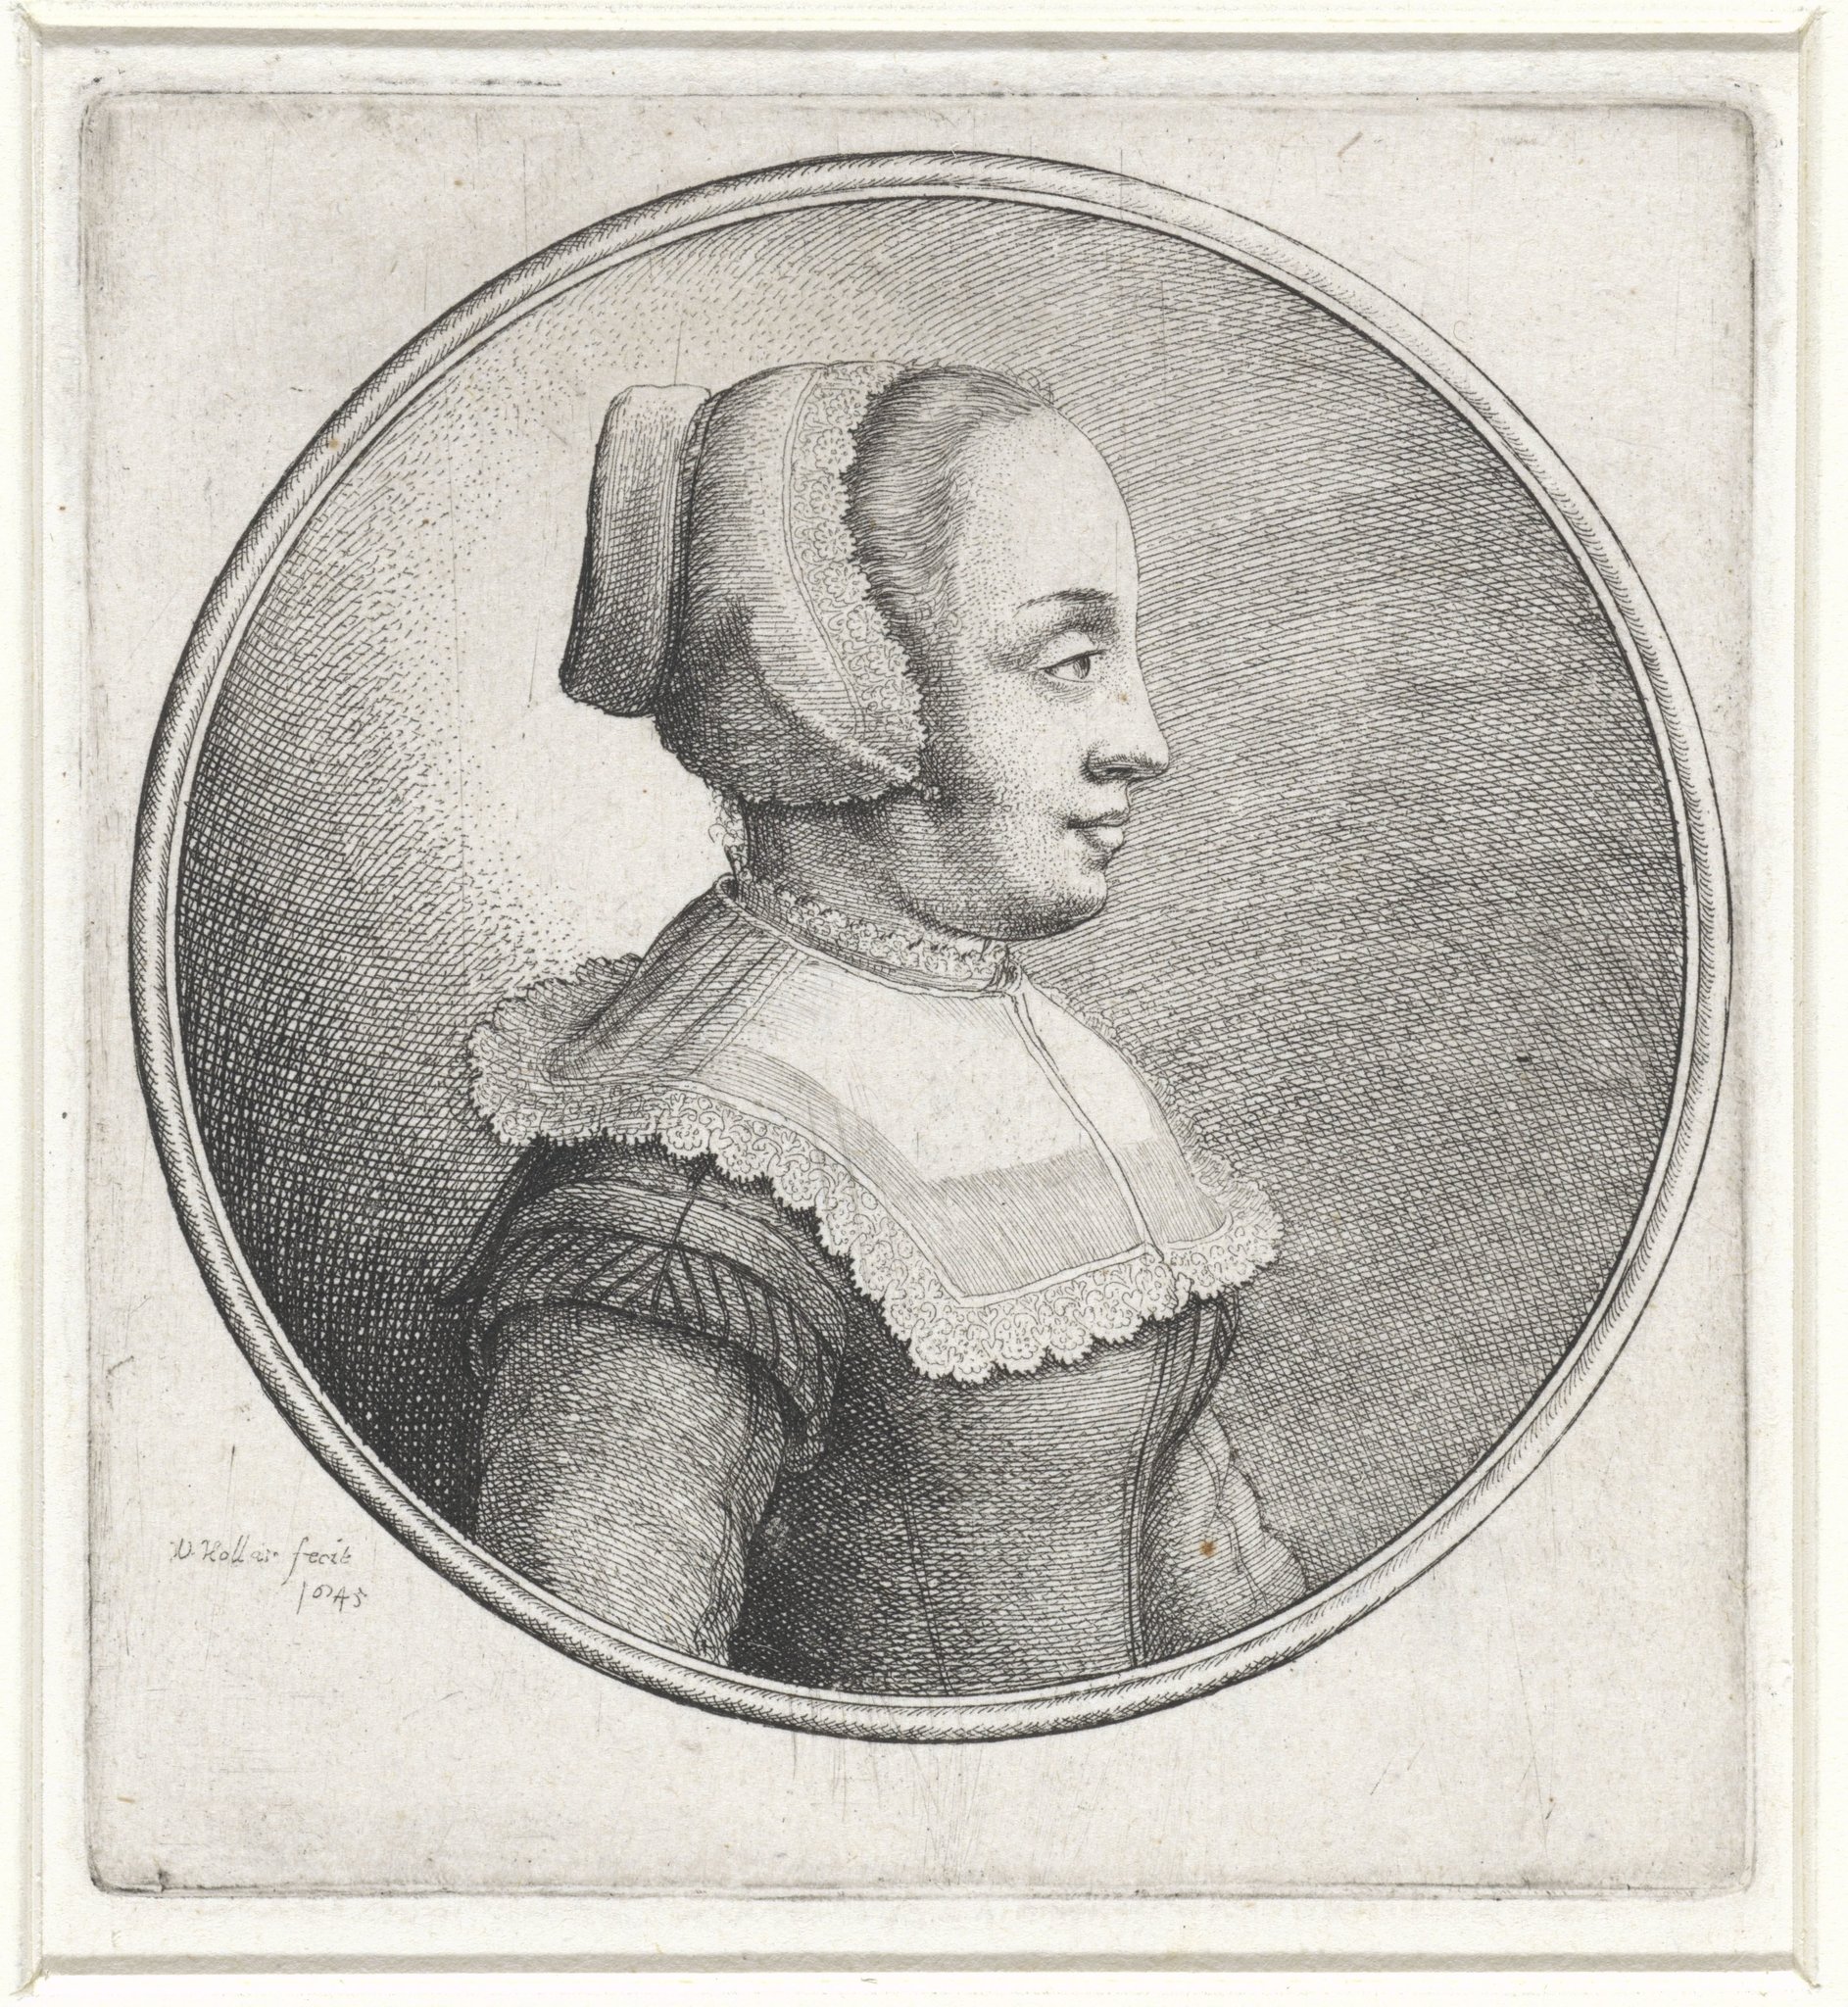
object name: print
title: Vrouwenbusten in ronde lijsten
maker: wenceslaus hollar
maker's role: draughtsman, print maker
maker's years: 1607-1677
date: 1645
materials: paper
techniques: etching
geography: antwerp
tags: anonymous historical person portrayed alone - bb - woman, head-gear: cap (+ women's clothes), neck-gear: collar (+ women's clothes)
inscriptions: collector's mark: Lugt 2228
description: De prent maakt deel uit van een 23-delige serie met verschillende vrouwenbusten in ronde lijsten.